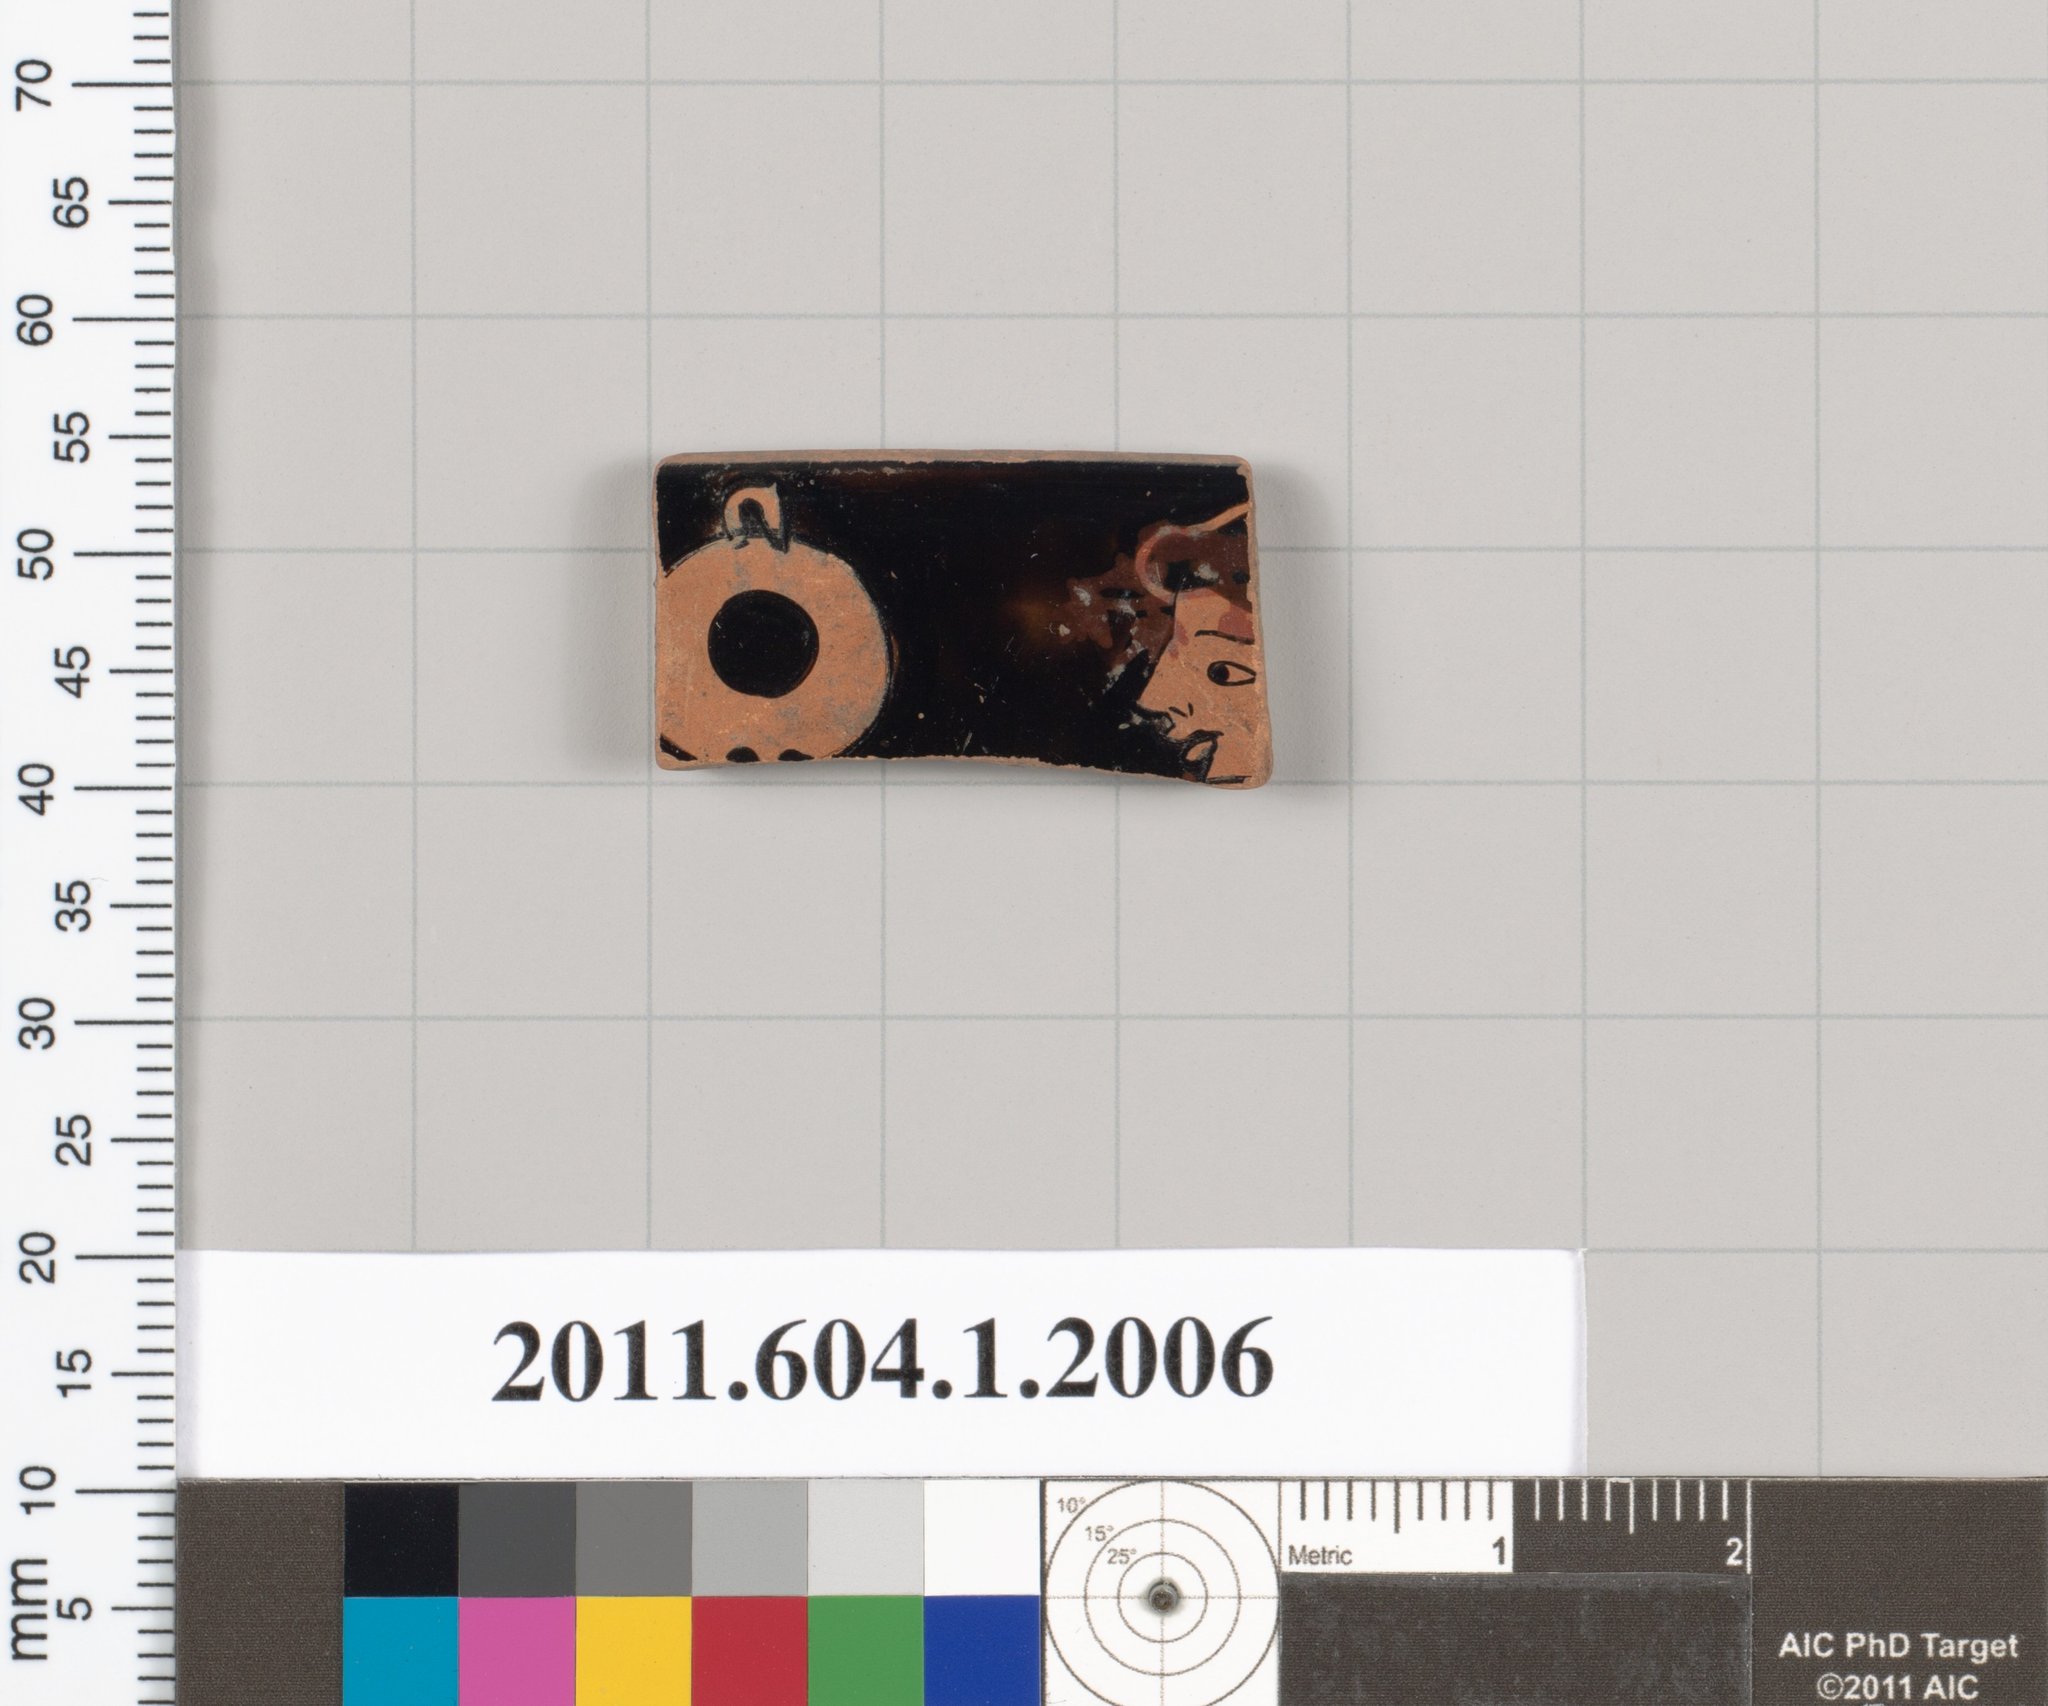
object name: kylix fragment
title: Terracotta rim fragment of a kylix (drinking cup)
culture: greek, attic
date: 475-451 BCE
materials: terracotta